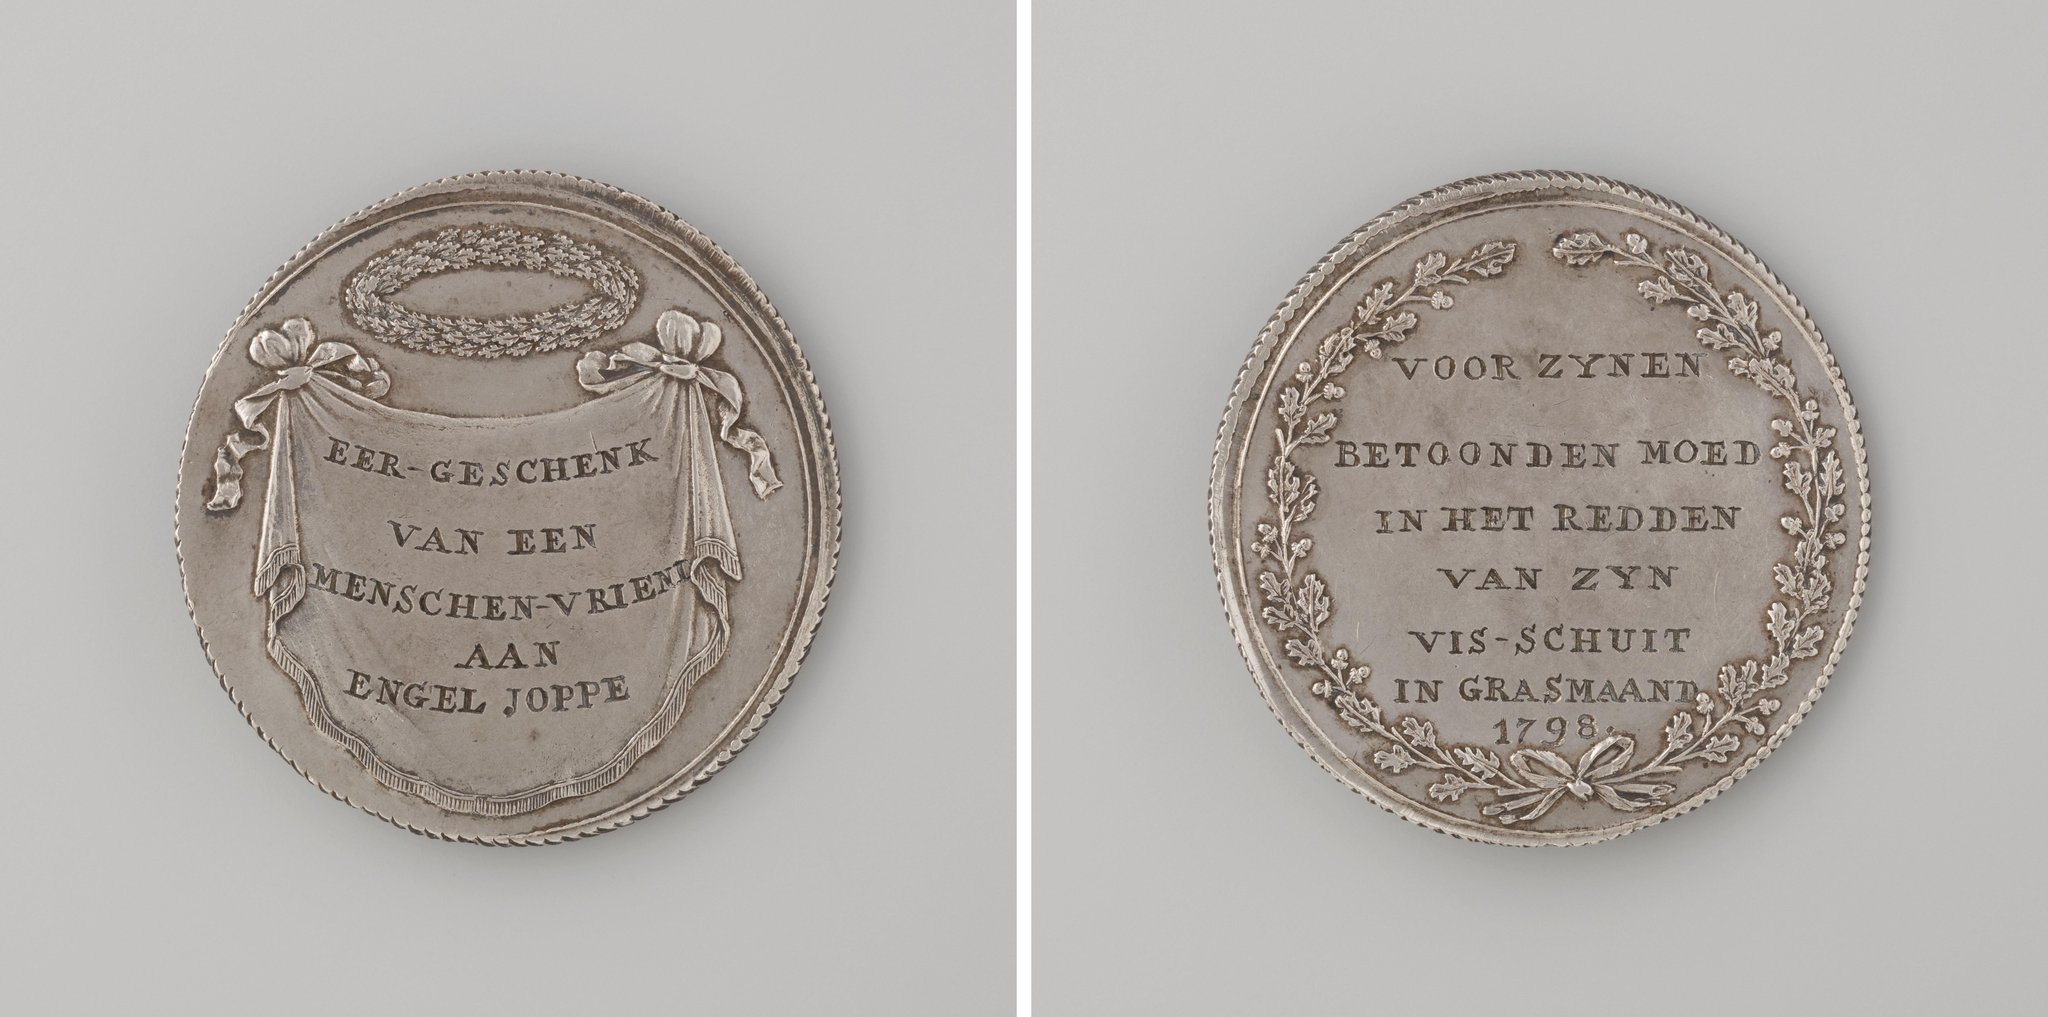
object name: honorary medal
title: Geschenk aan Engel Joppe voor het redden van zijn visserschip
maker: Anonymous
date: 1798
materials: silver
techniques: striking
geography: netherlands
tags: engel joppe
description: Zilveren penning. Voorzijde: opschrift op doek, waarvan bovenste uiteinde met linten zijn versierd, bekroond met eikenkrans. Keerzijde: opschrift binnen eikenkrans.